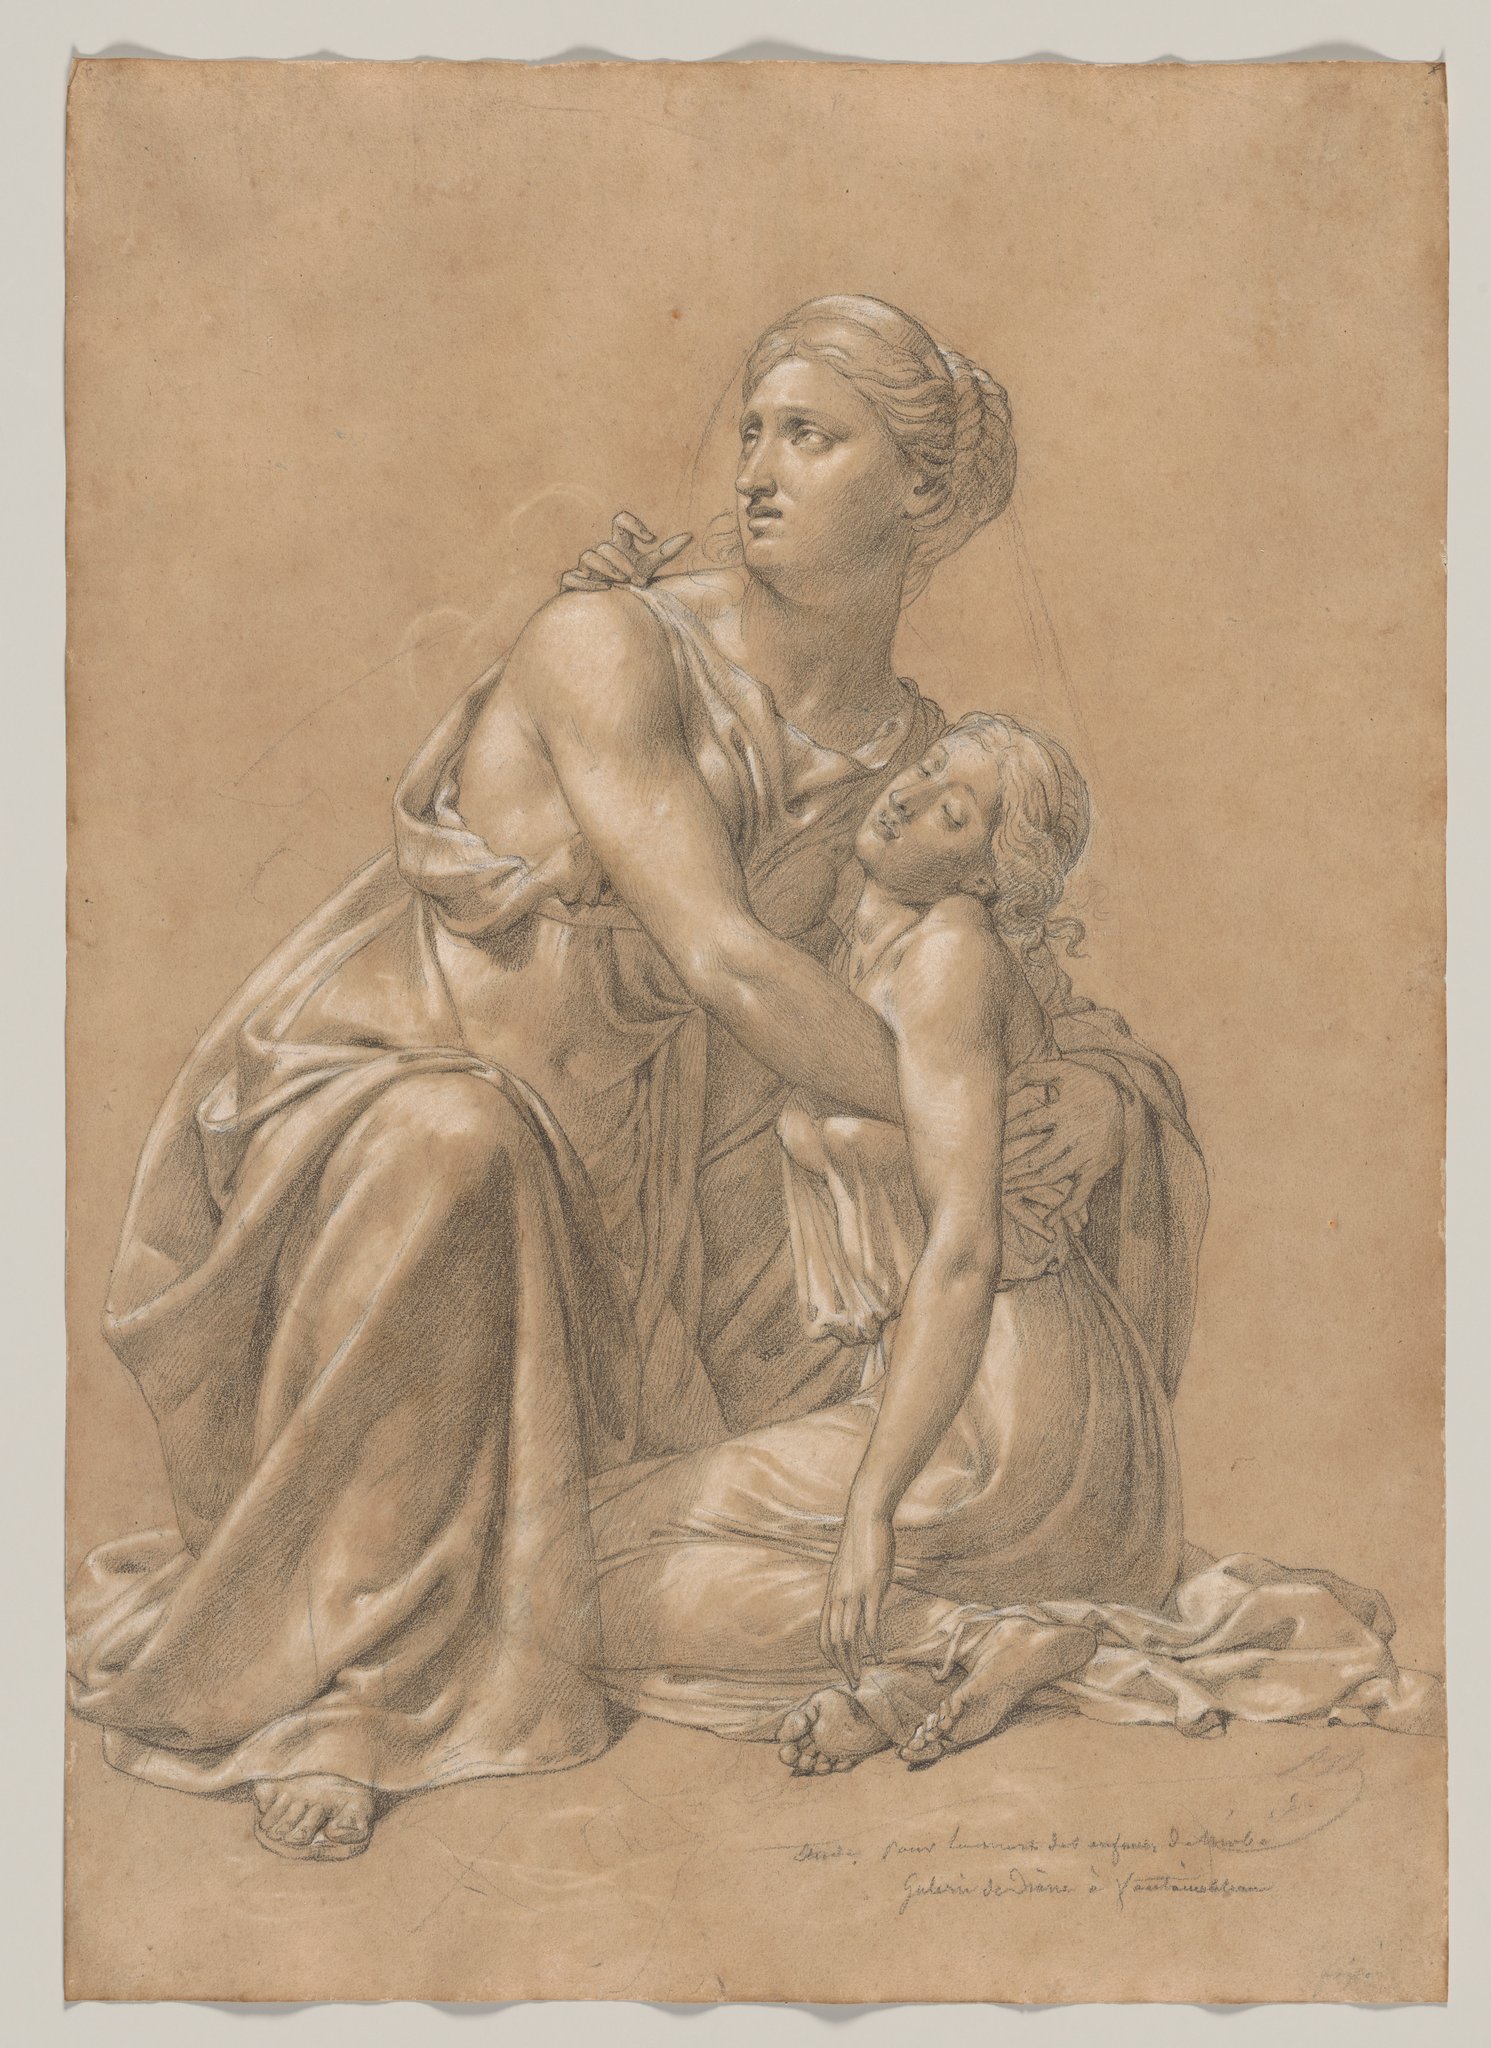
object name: drawing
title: The Punishment of Niobe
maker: merry joseph blondel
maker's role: artist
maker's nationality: french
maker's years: 1781-1853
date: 1822-1828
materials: chalk, crayon, paper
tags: women,niobe